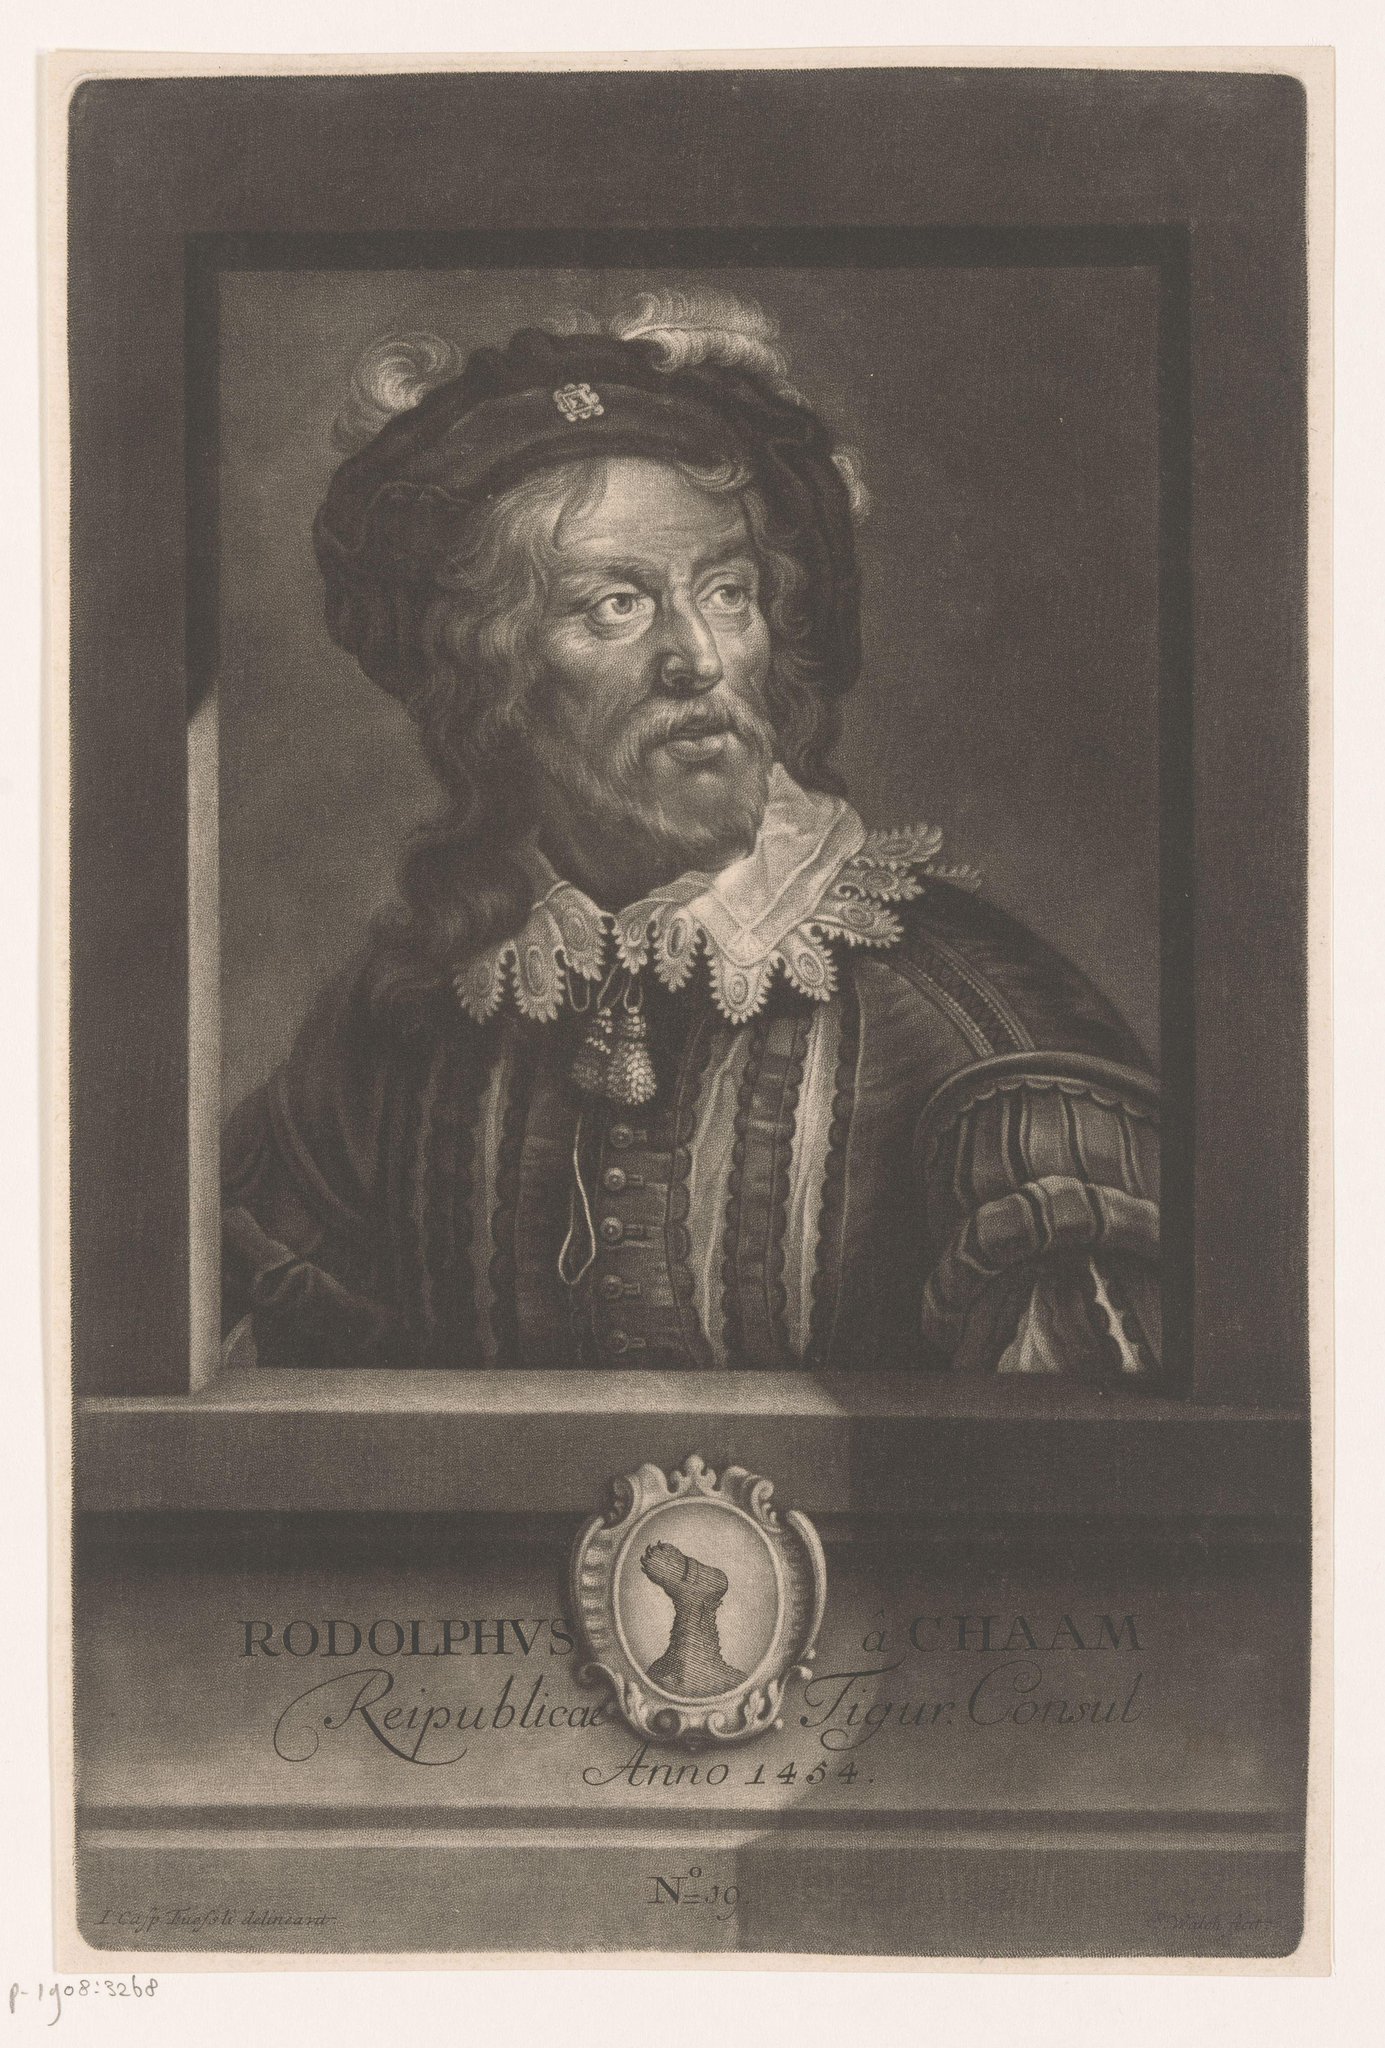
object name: print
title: Portret van Rudolf van Cham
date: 1731-1788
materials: paper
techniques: mezzotint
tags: historical persons, armorial bearing, heraldry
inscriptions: collector's mark: Lugt 2228